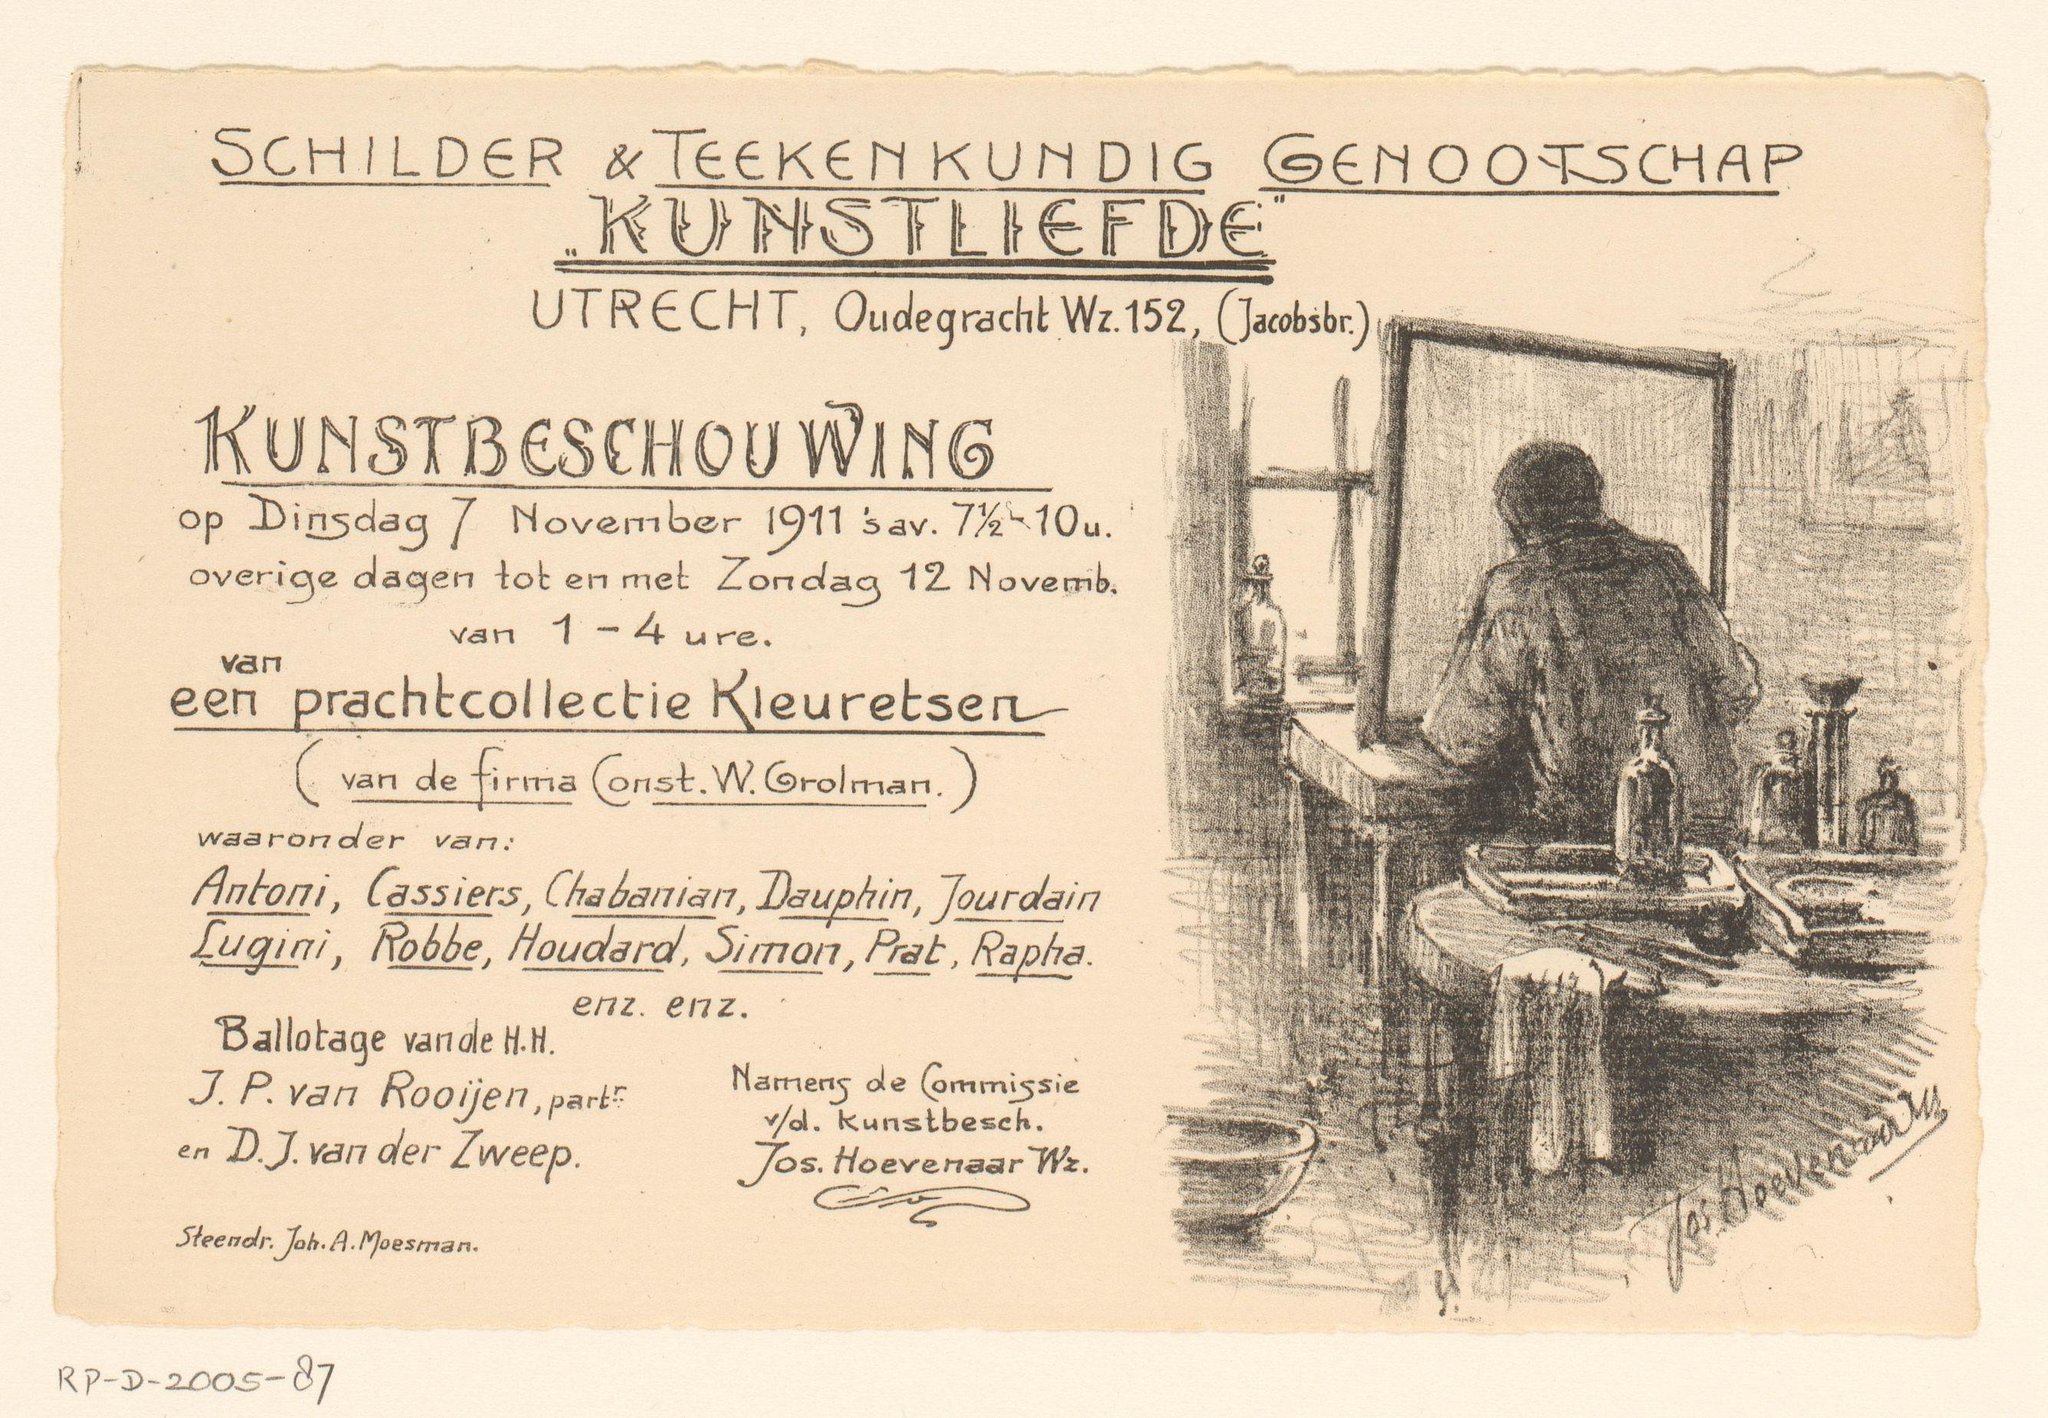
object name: invitation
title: Uitnodiging van Schilder- en Teekenkundig Genootschap "Kunstliefde" voor een kunstbeschouwing, 7 november 1911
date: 1911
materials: paper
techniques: lithograph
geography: utrecht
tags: criticizing and discussing art, art criticism, circle, club of artists, collecting and exhibiting products of the fine arts, portrait, self-portrait of graphic artist (+ artist at work)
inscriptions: collector's mark: Lugt 2228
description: Etser aan het werk in het atelier. Uitnodiging van Schilder- en Teekenkundig Genootschap "Kunstliefde" voor een kunstbeschouwing op 7 november 1911 van een collectie kleurenetsen van de firma Const. W. Grolman.